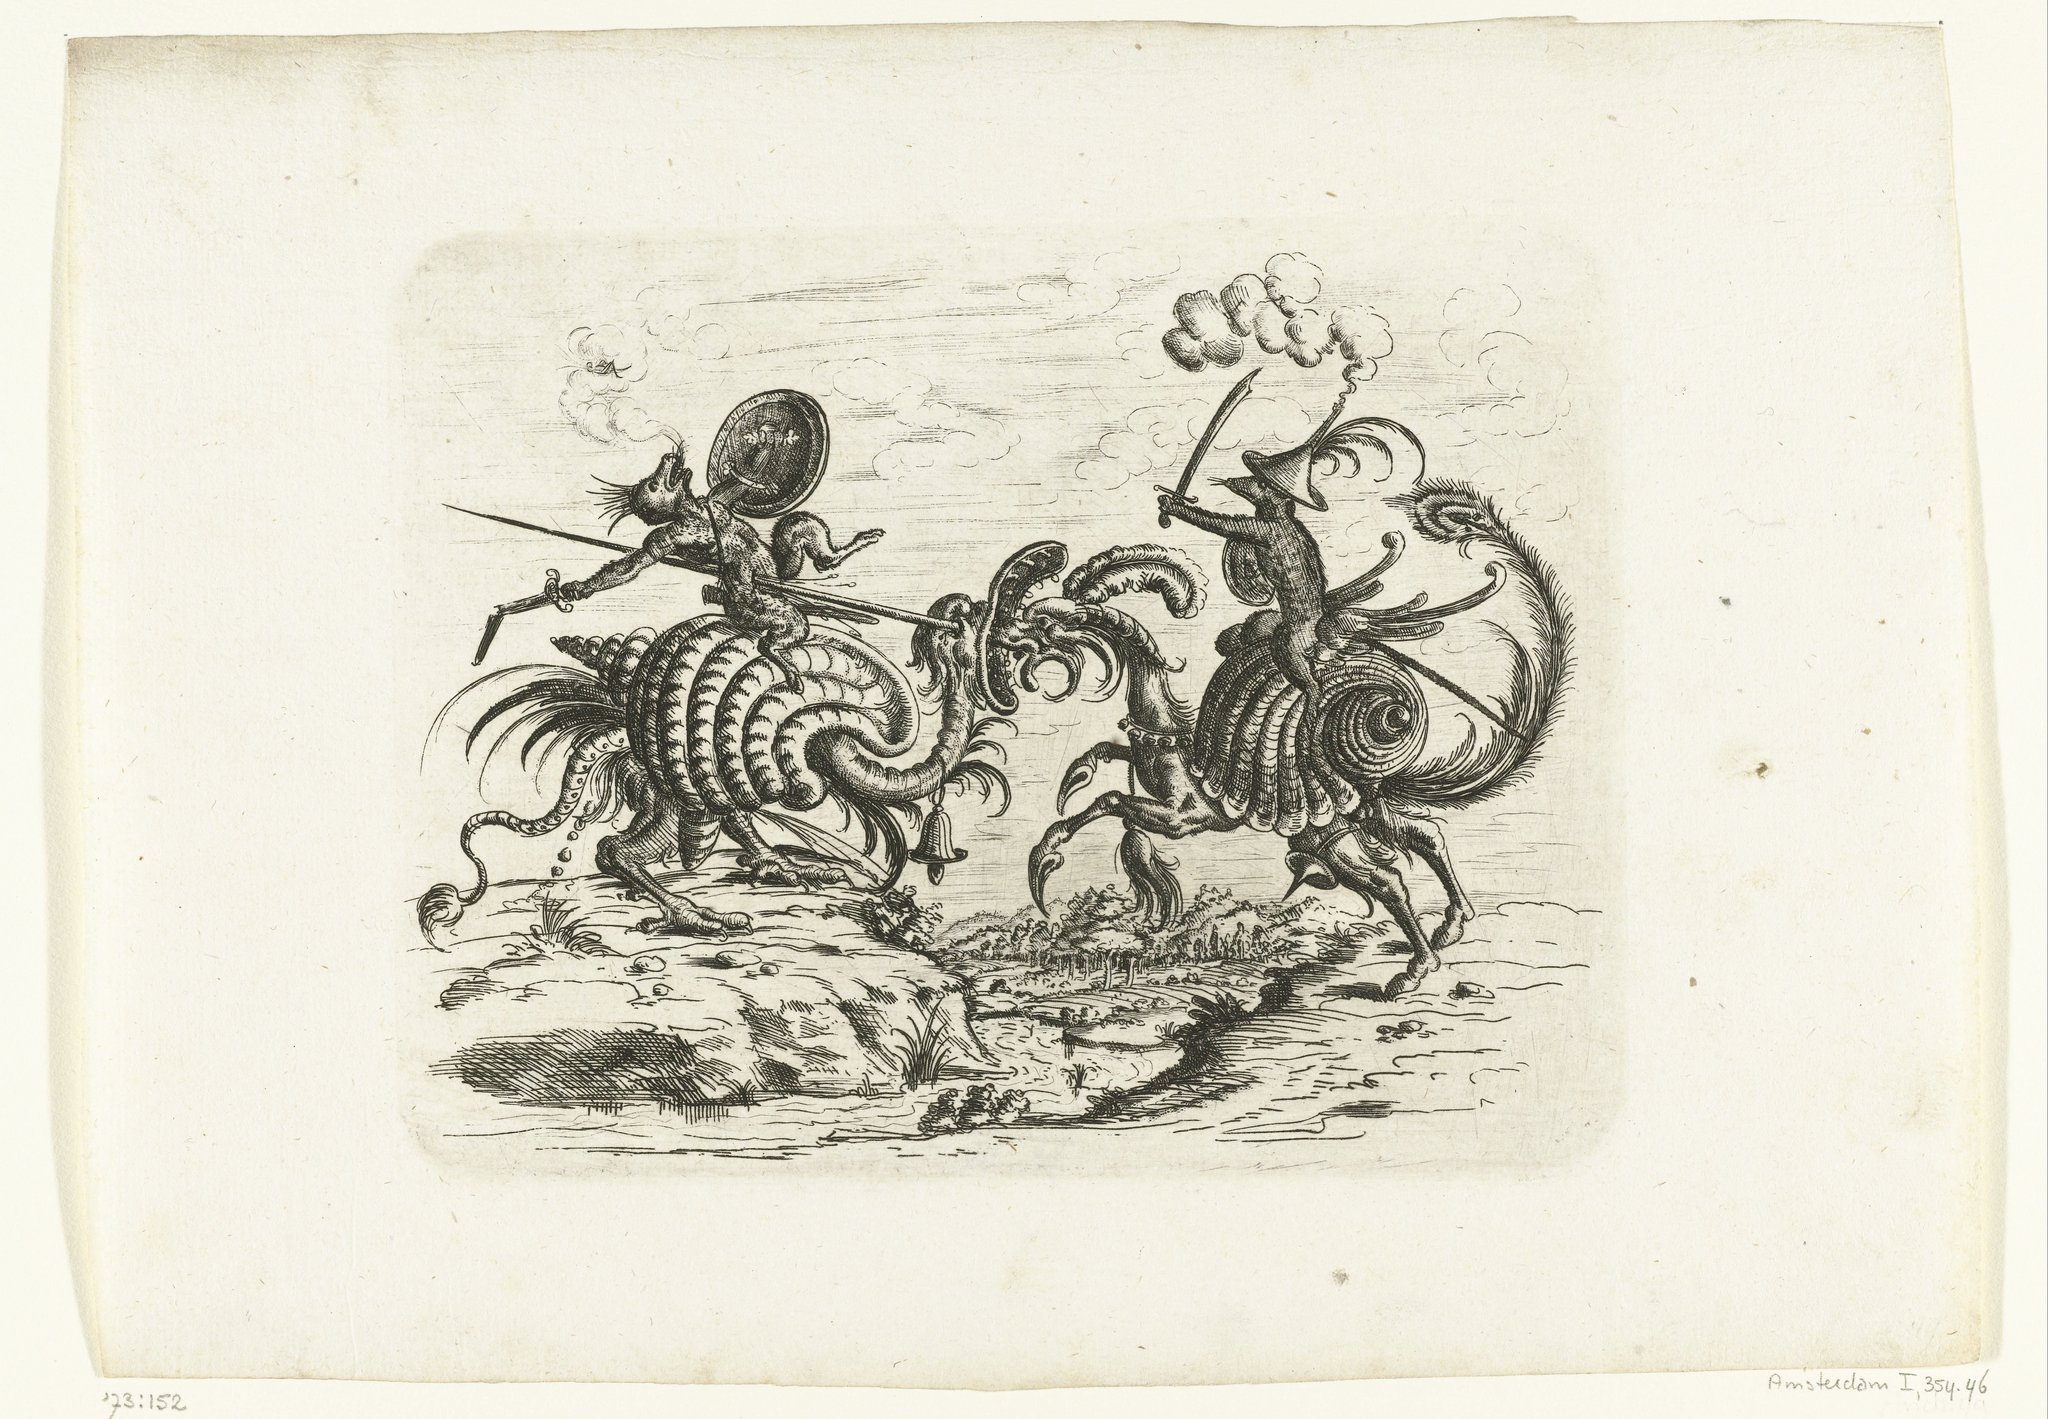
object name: ornament print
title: Das Neuw Grottesken Buch Nürnberg 1610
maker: christoph jamnitzer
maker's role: draughtsman, goldsmith, print maker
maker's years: 1563-1618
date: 1573-1610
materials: paper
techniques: etching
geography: germany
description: De aap rijdt op een fantastisch wezen met een slakkenhuis als lichaam en de rat rijdt op een fantastisch wezen met een geweldige hoorn op zijn snuit. Blad uit een serie vlakdecoraties met grotesken, cartouches, ovalen, mascarons, putti en fantastische wezens. De serie bestaat uit drie titelbladen, twee tekstbladen met de opdracht en het voorwoord en 60 bladen, verdeeld over drie boeken.